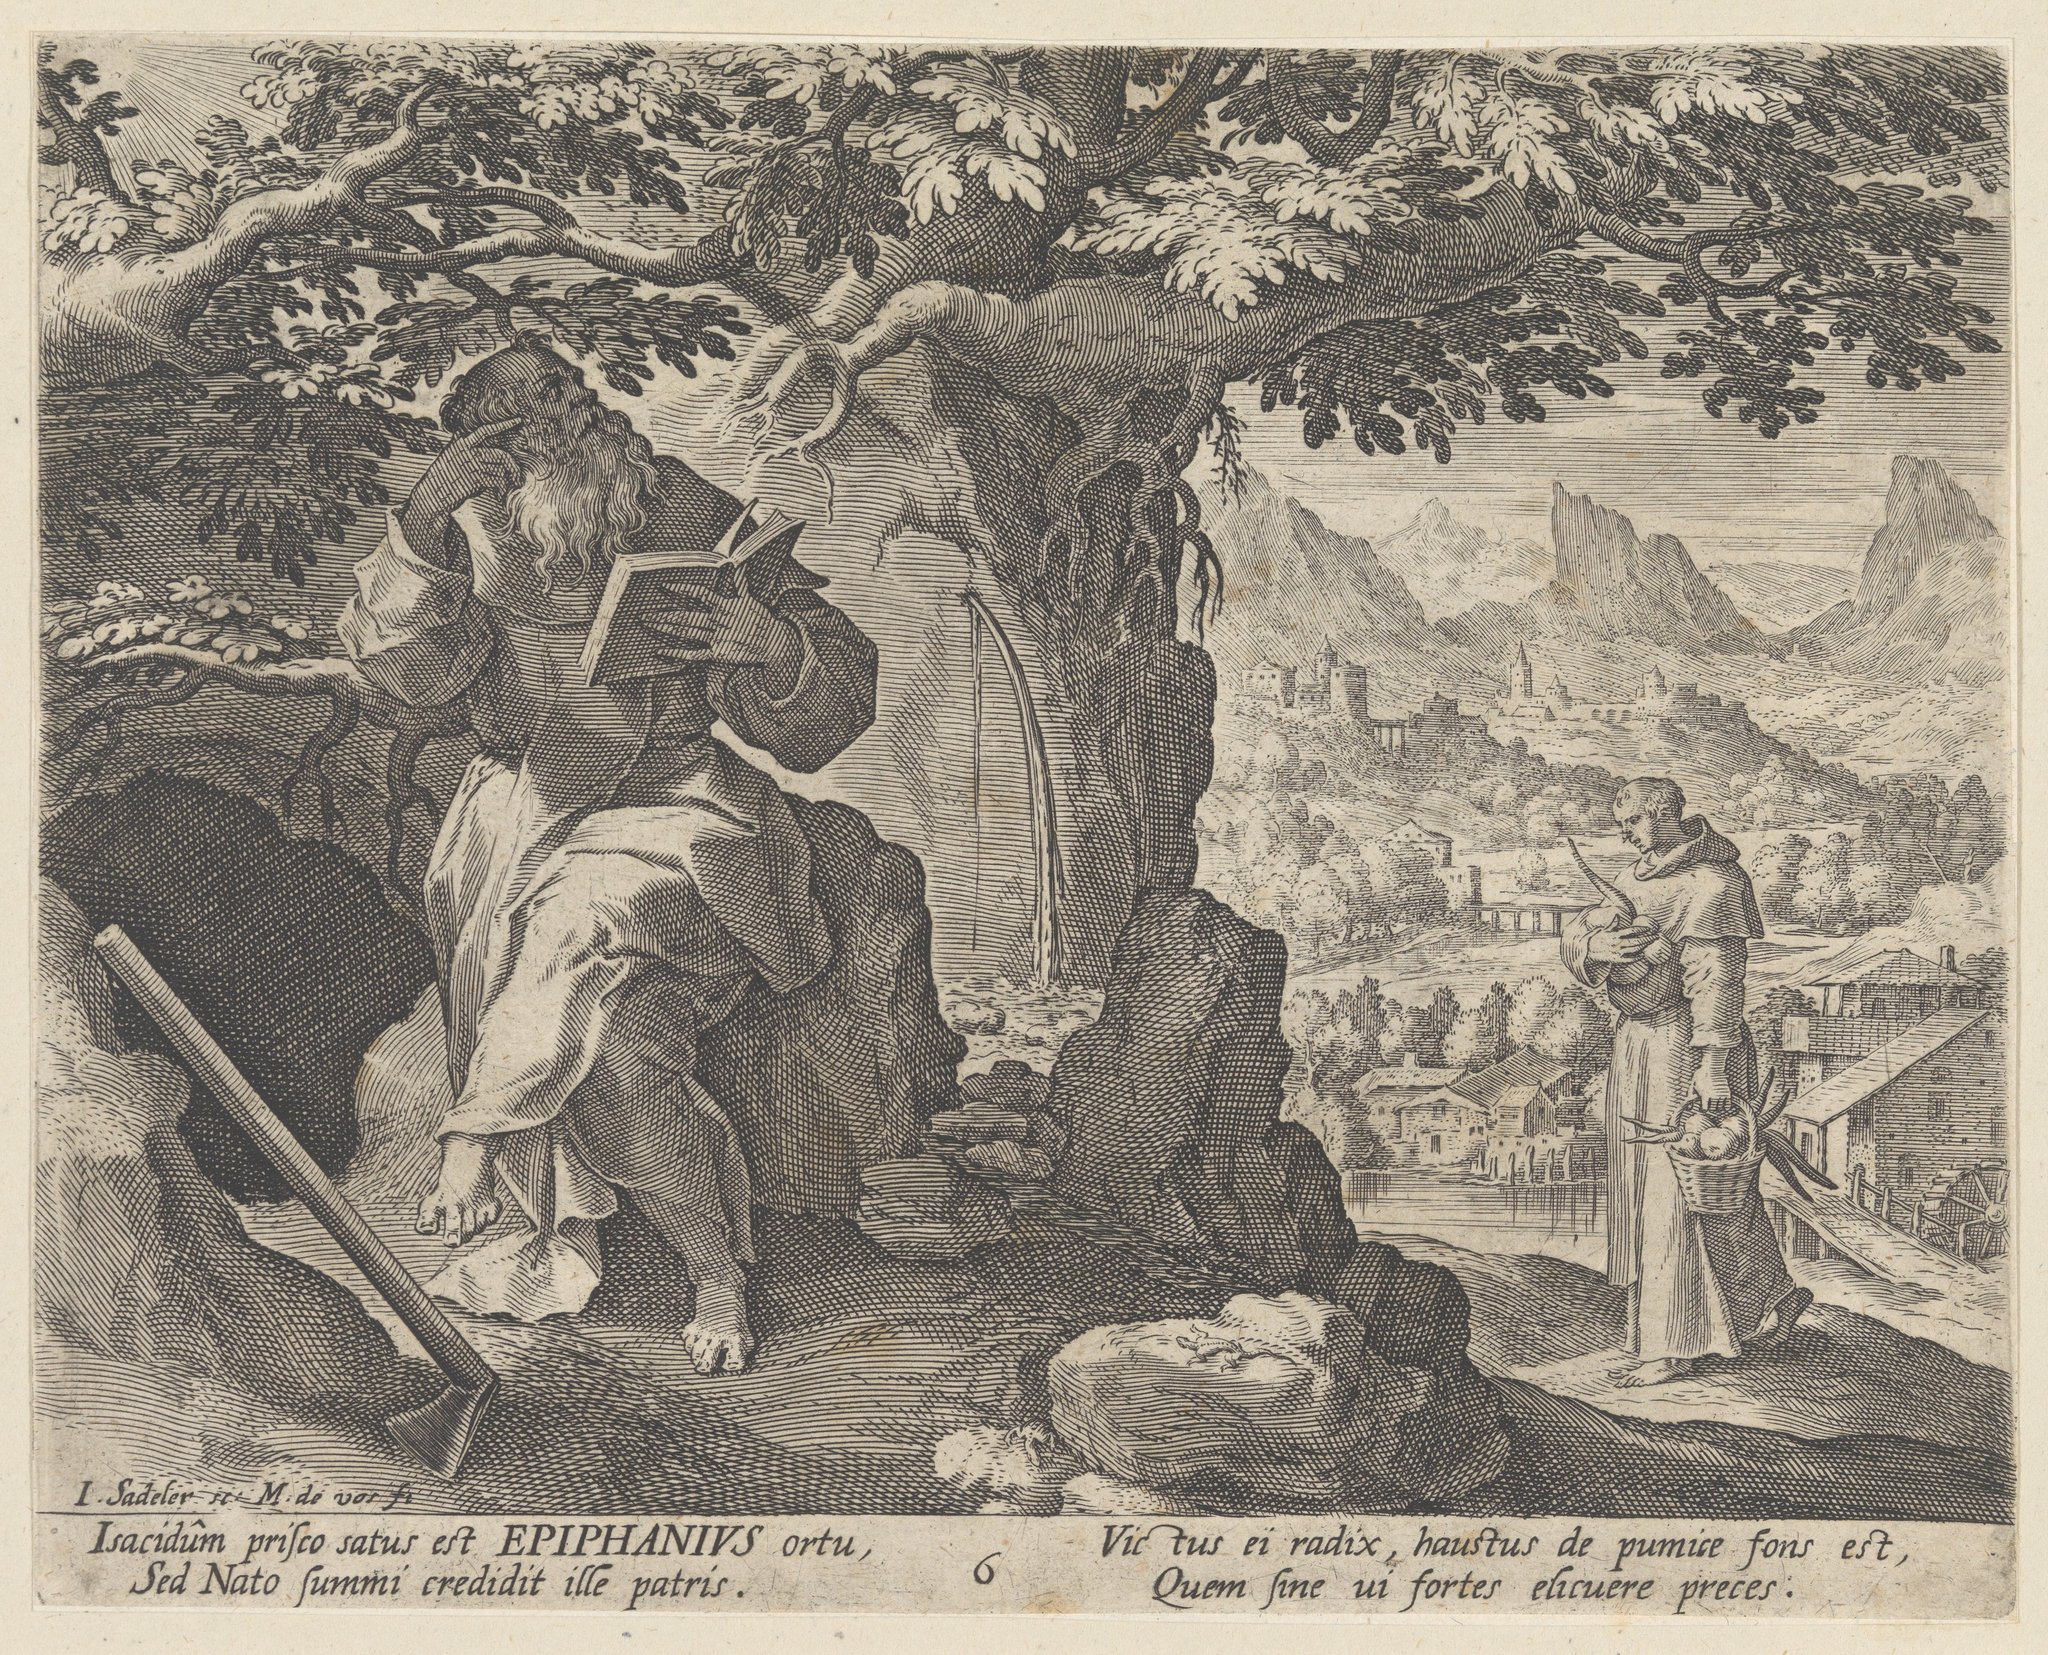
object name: print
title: Epiphanius, from "Sylvae Sacrae Monumenta...Anachoretarum"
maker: maerten de vos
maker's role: artist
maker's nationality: netherlandish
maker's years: 1532-1603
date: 1593-1594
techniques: engraving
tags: men,trees,bishops